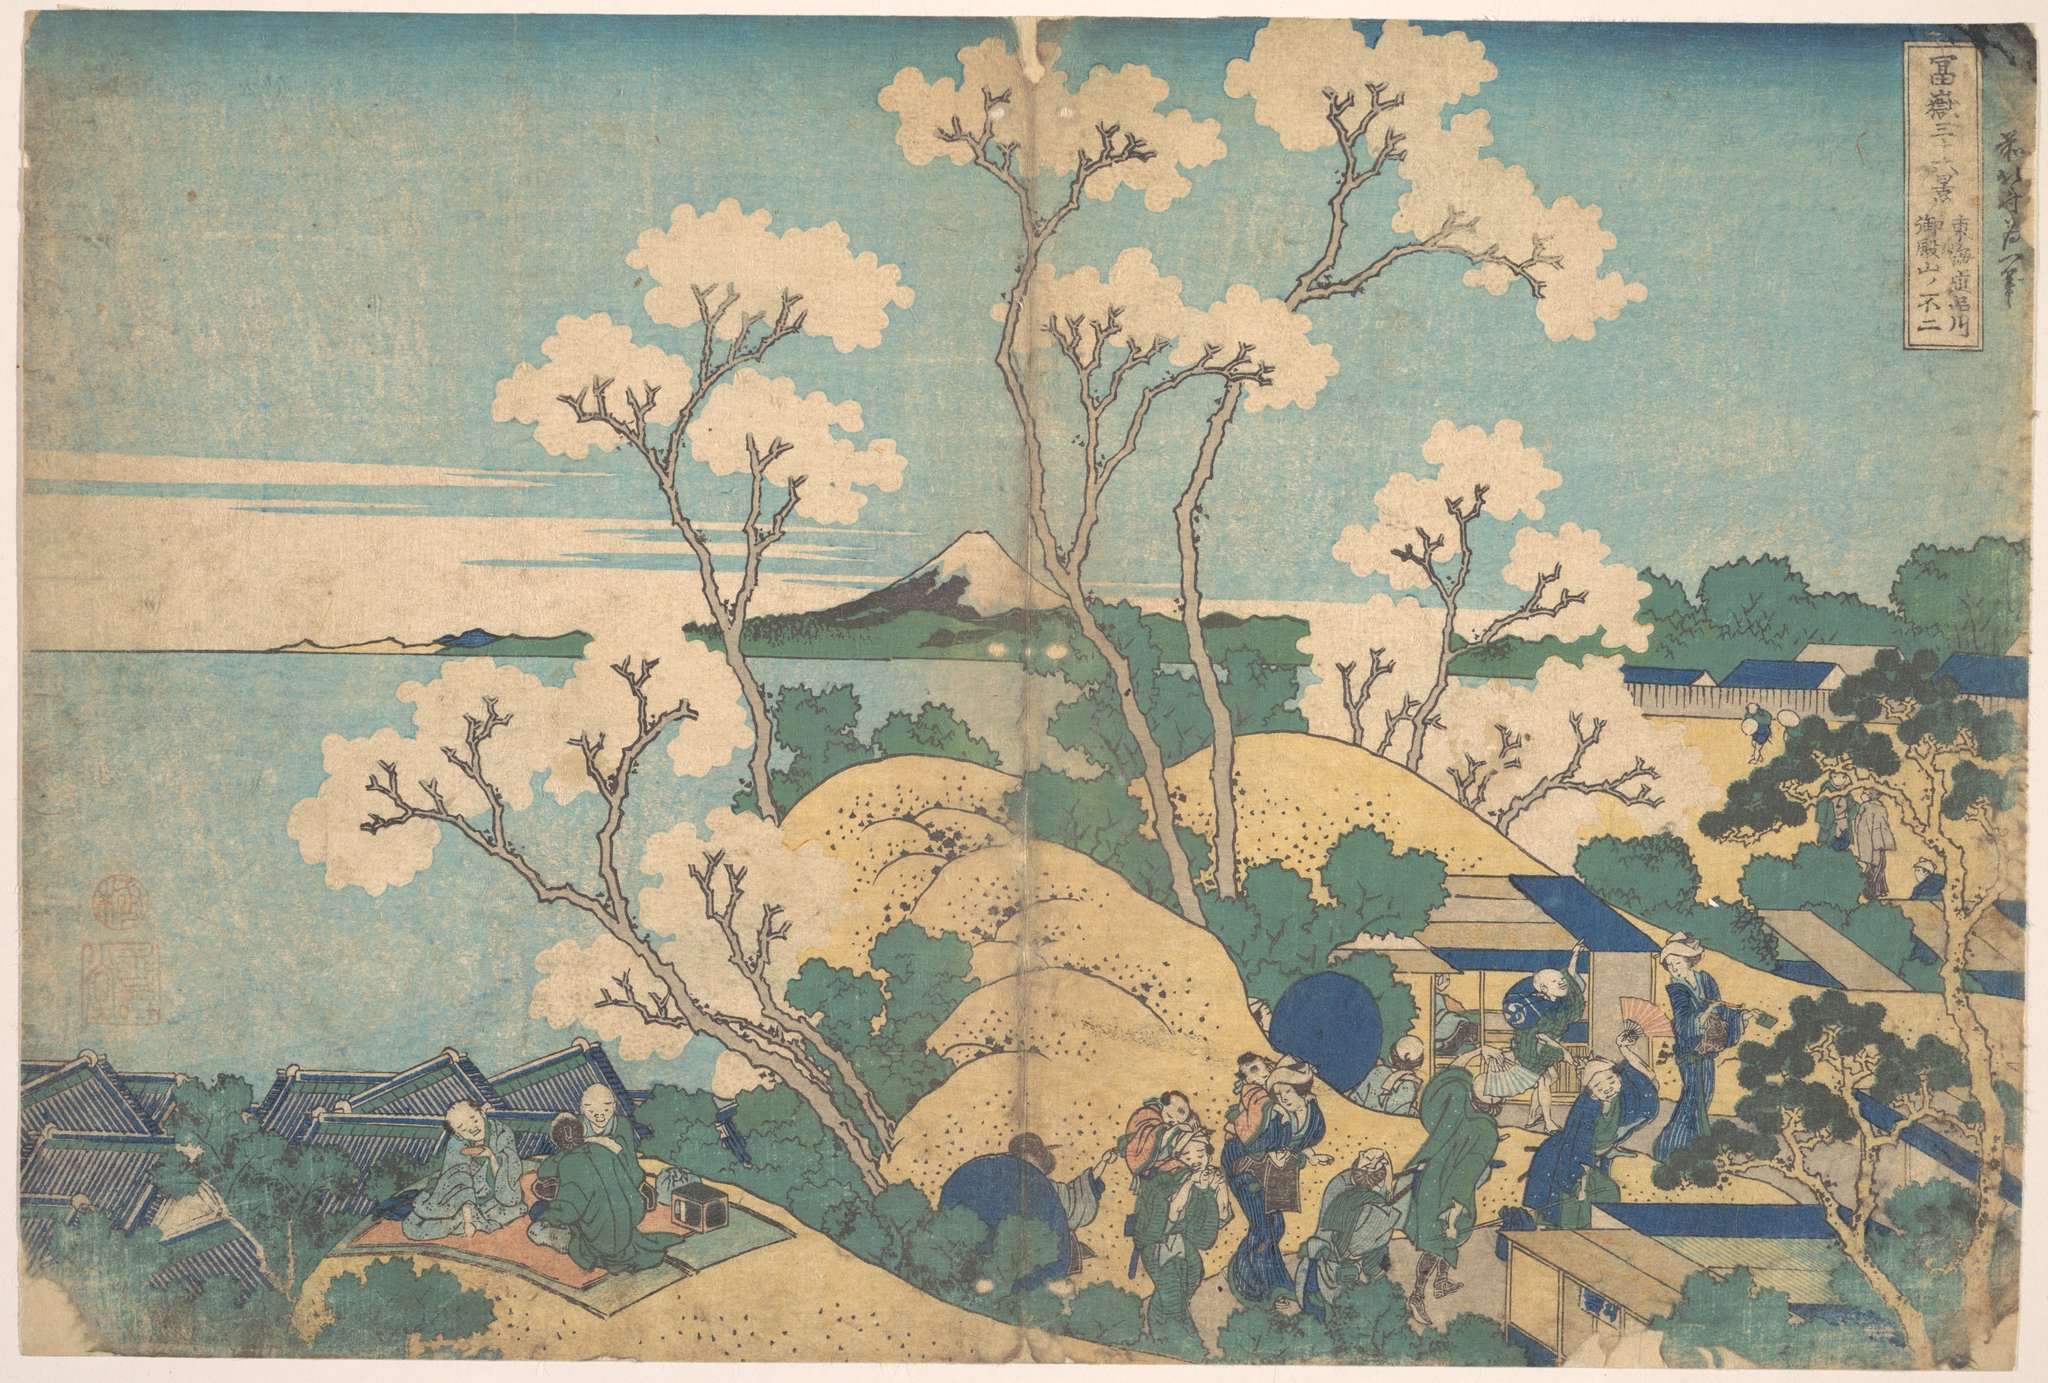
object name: woodblock print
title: Fuji from Gotenyama at Shinagawa on the Tōkaidō (Tōkaidō Shinagawa Gotenyama no Fuji), from the series Thirty-six Views of Mount Fuji (Fugaku sanjūrokkei)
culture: japanese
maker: katsushika hokusai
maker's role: artist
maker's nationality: japanese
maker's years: 1760-1849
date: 1830-1832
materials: ink, paper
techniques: woodblock print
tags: human figures,trees